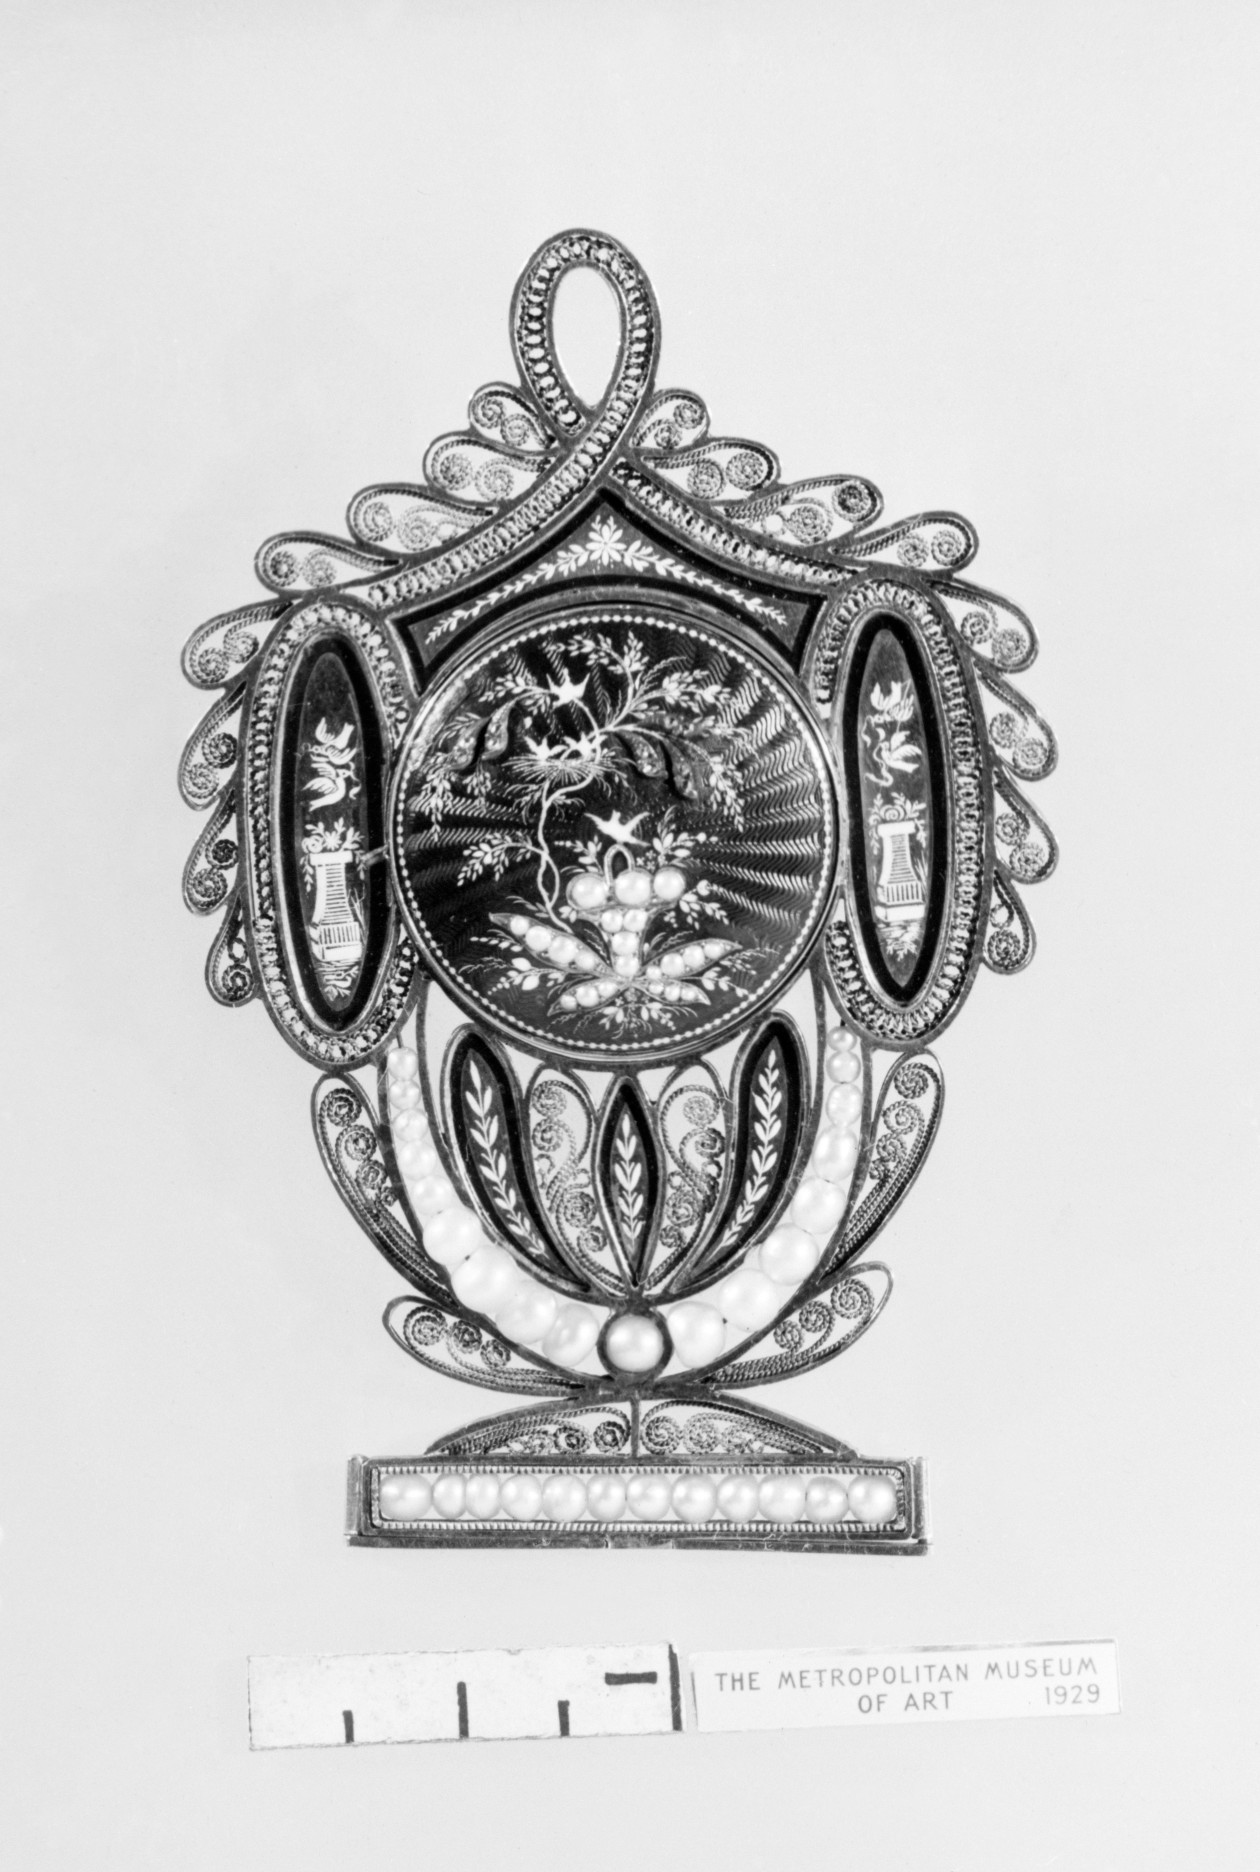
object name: watch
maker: modge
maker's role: maker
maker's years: 1775-1875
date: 1801-1833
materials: enamel, gold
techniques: enamel, painting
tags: birds,trees